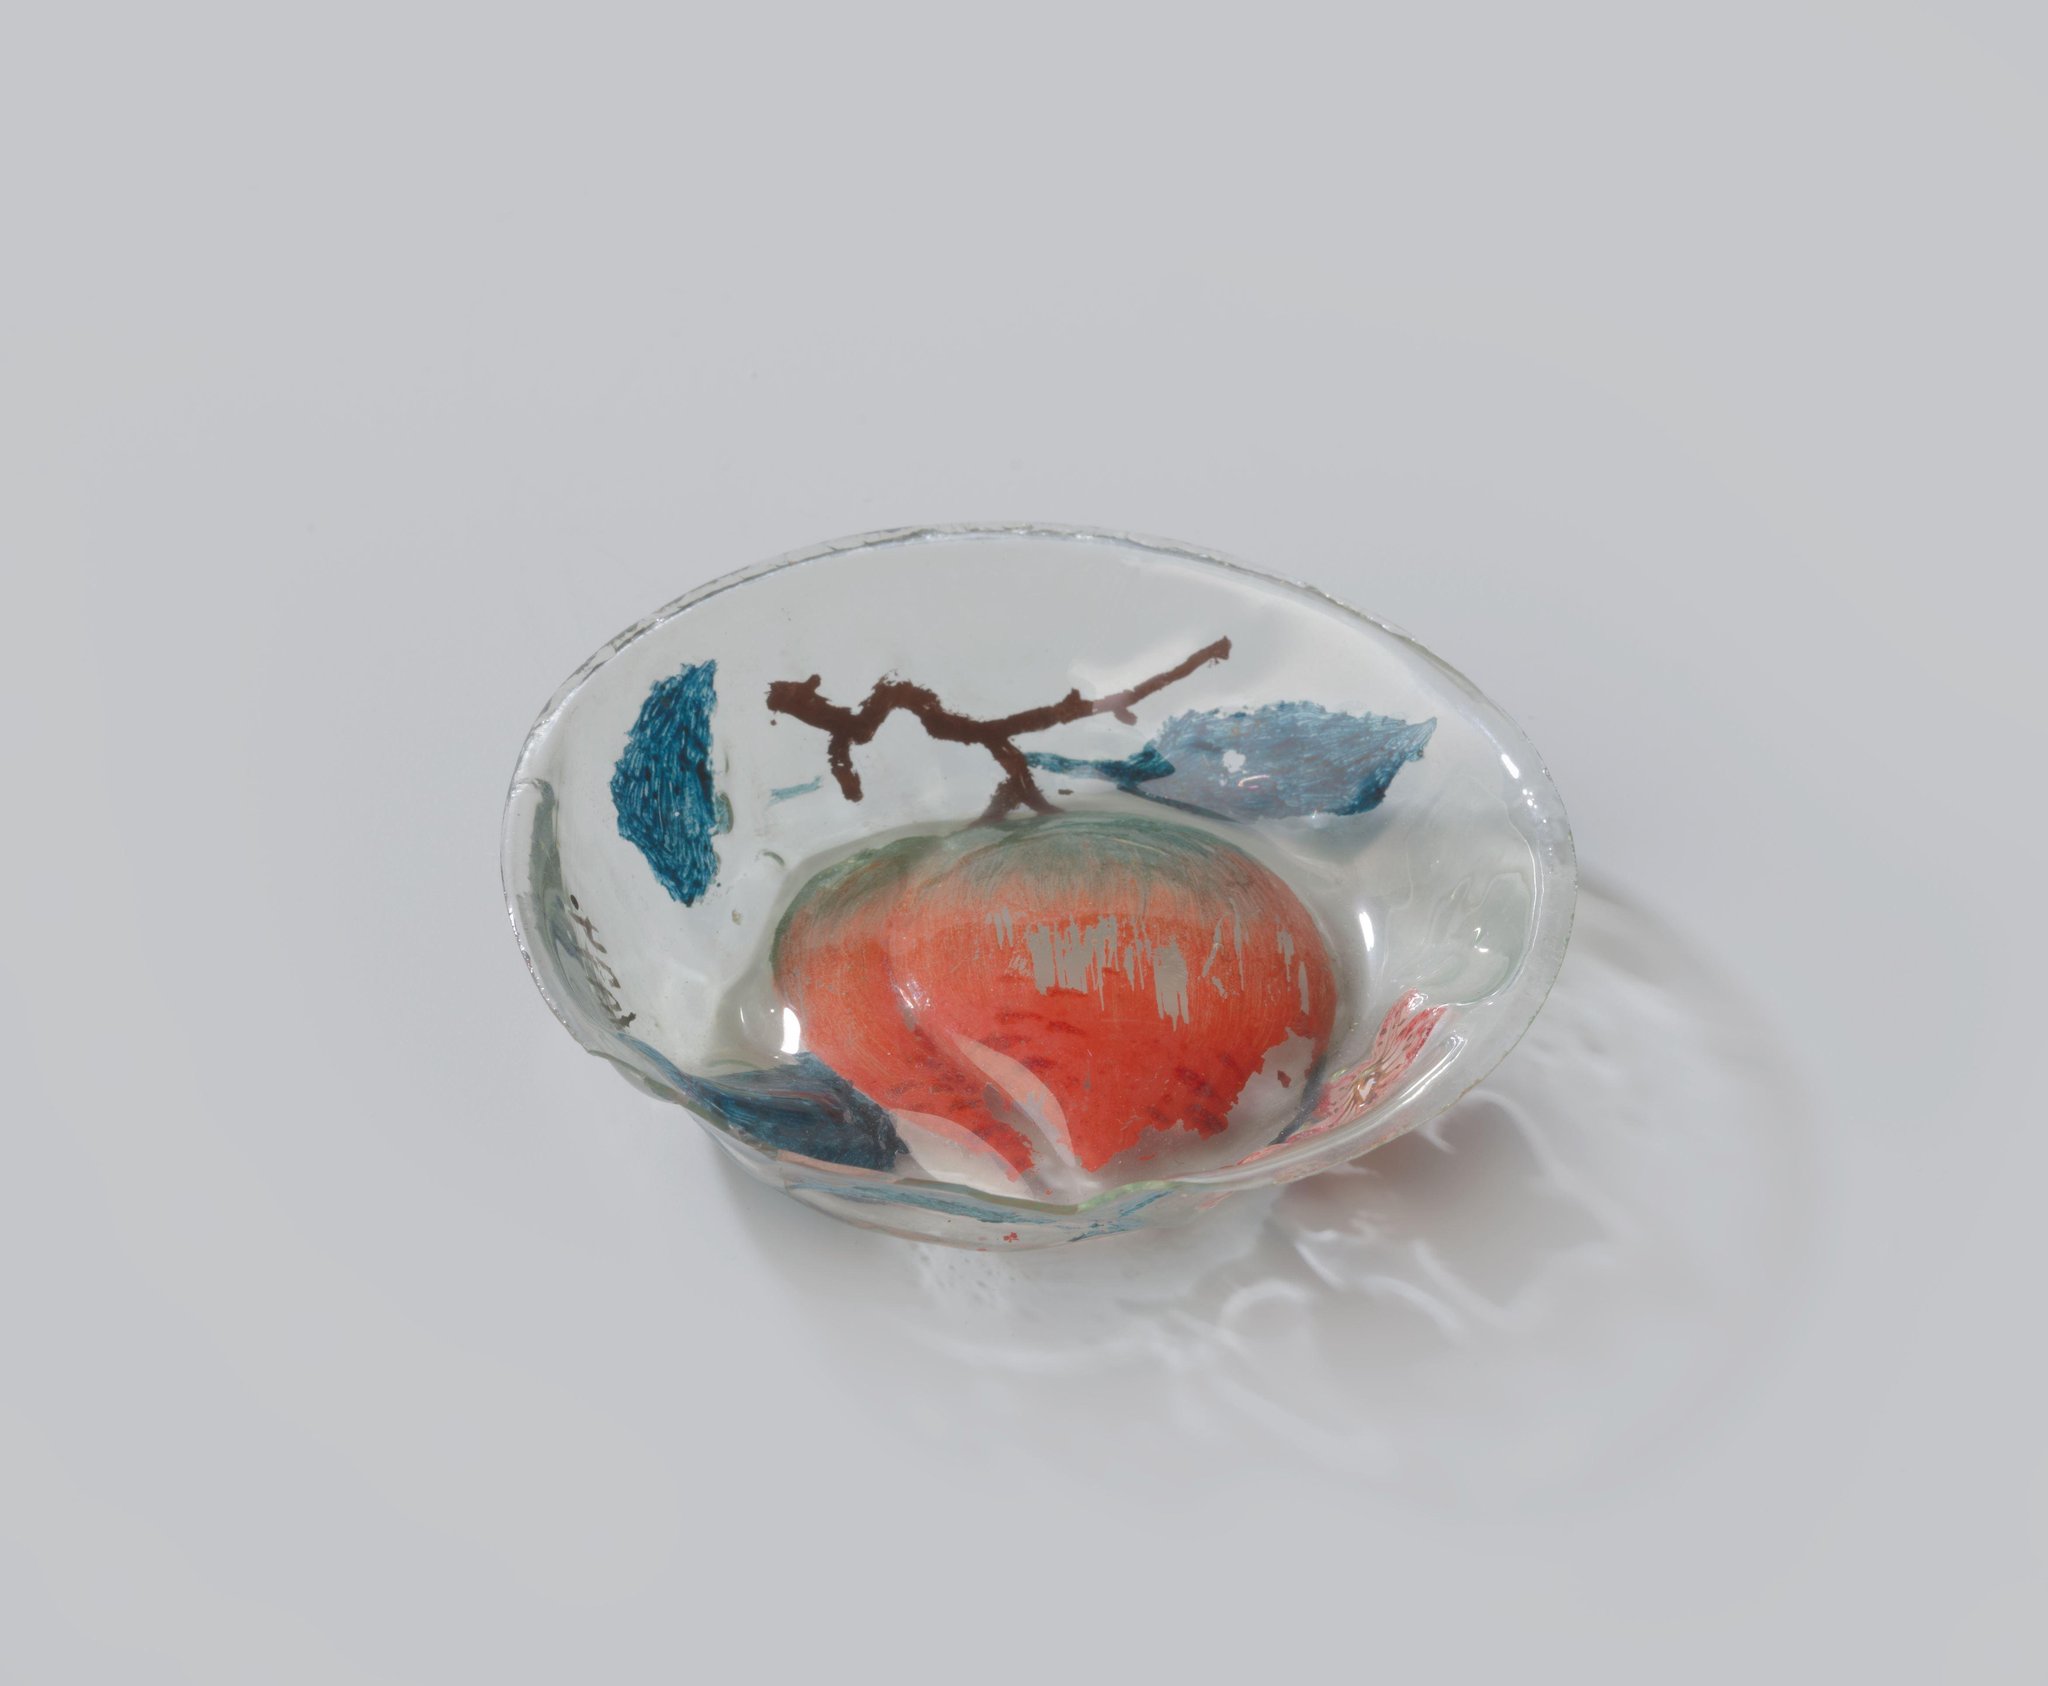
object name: platter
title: Schotel van glas, met perzik en bloem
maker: Anonymous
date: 1800-1900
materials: glass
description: Schotel van glas, met perzik en bloem. Zie ook BK-NM-6994-2.